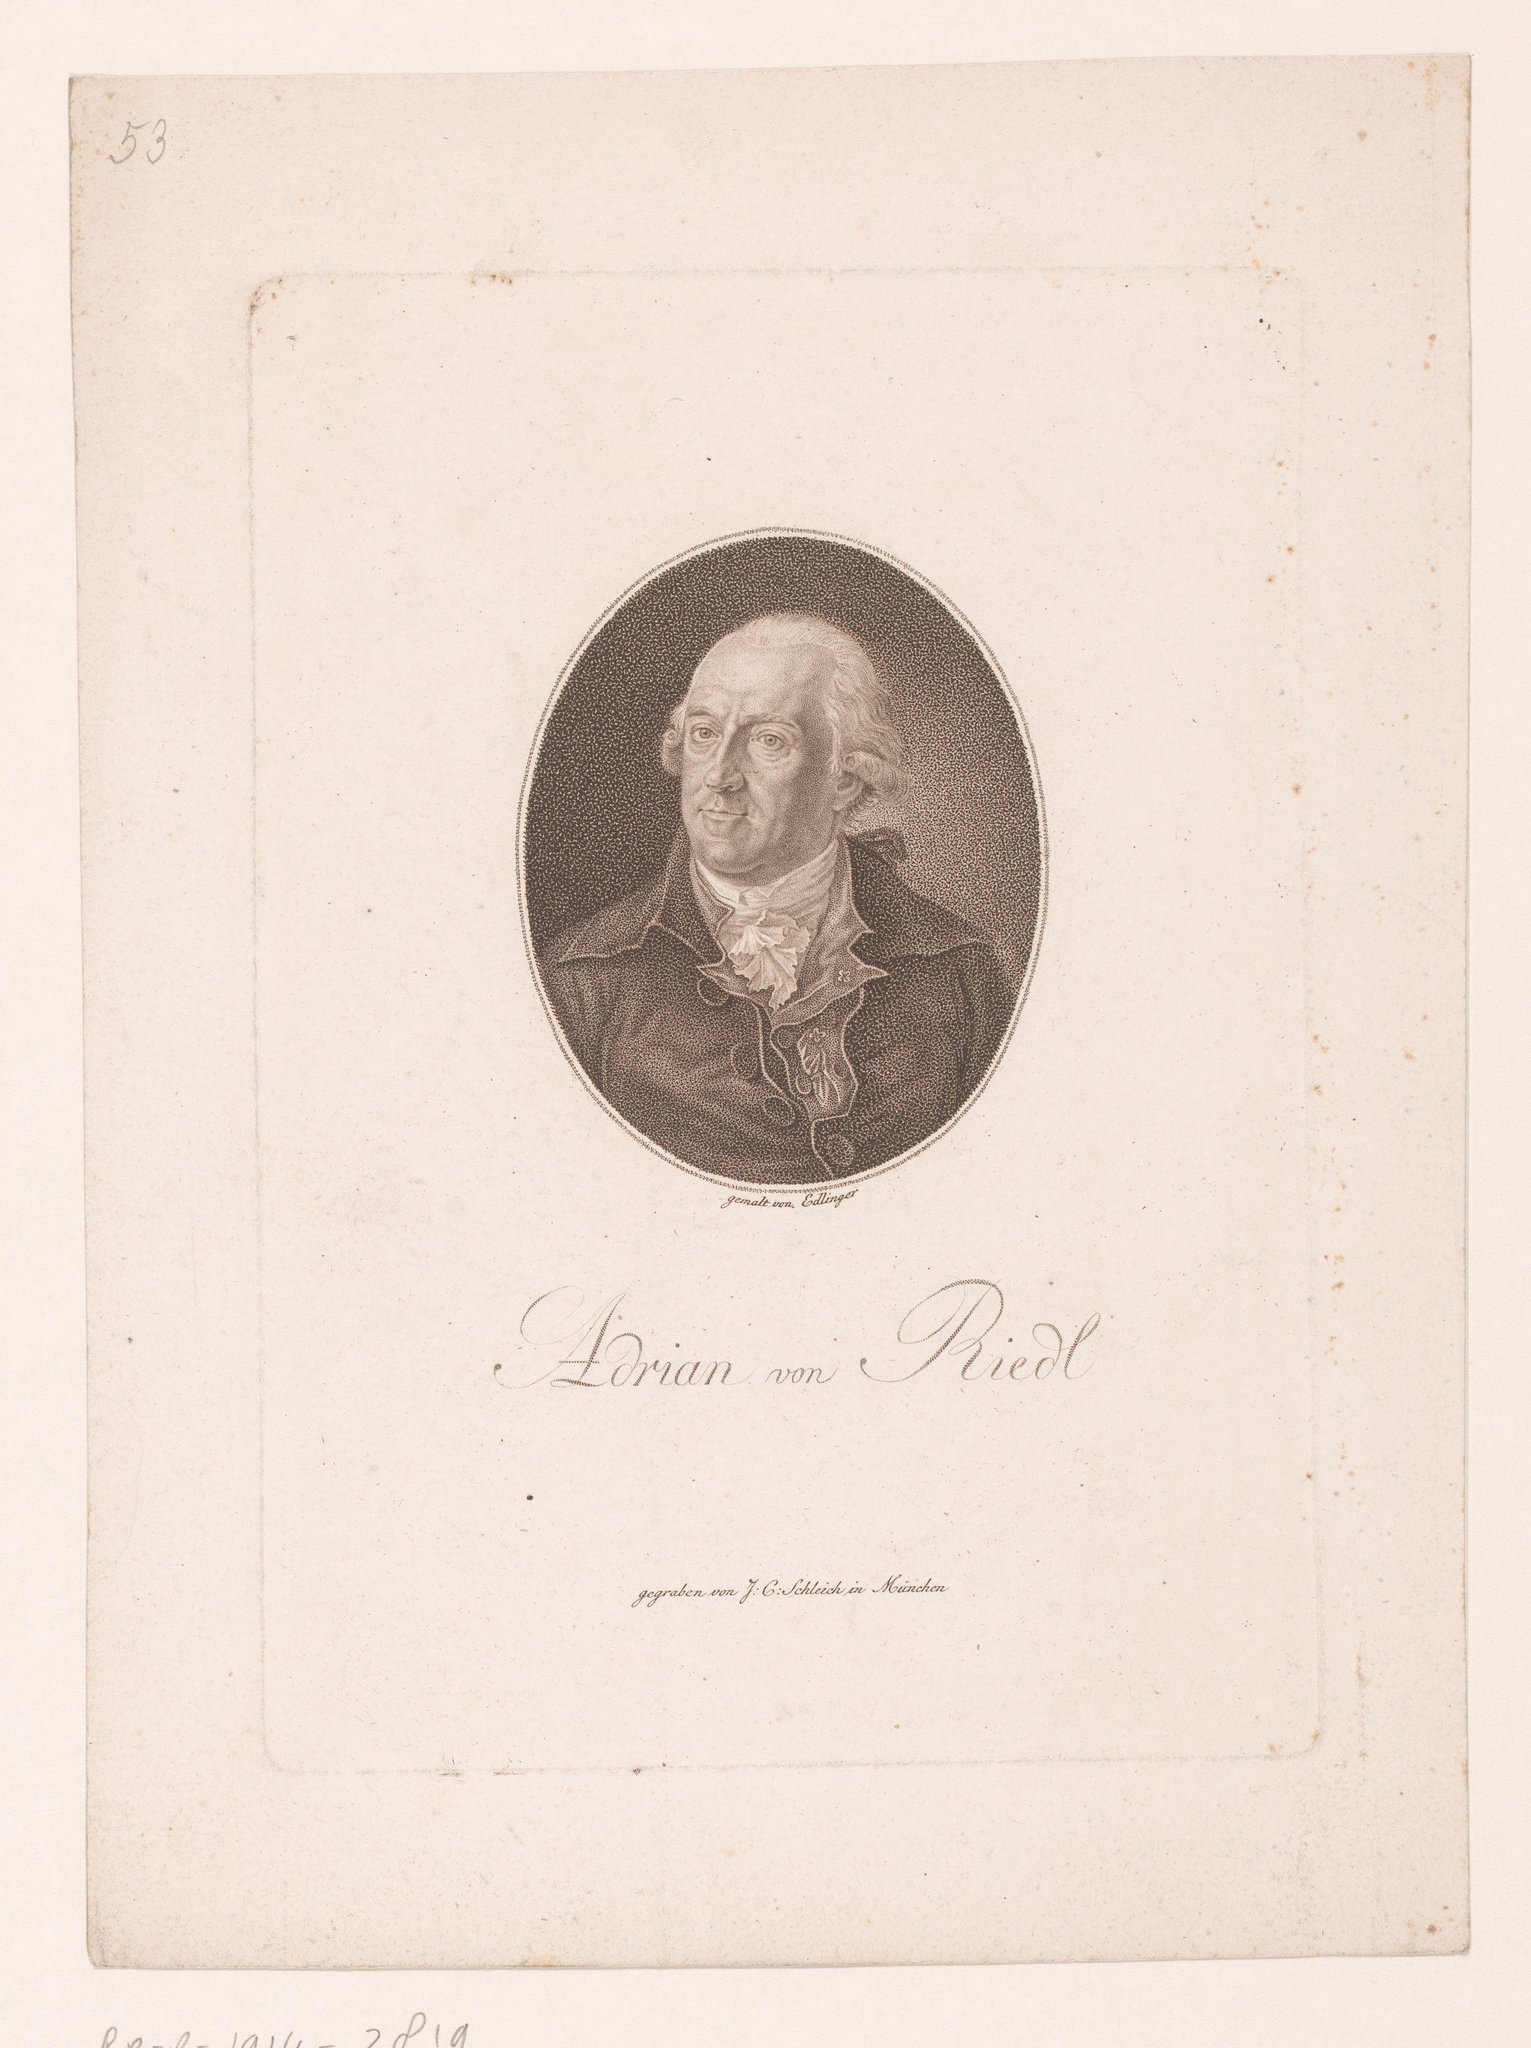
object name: print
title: Portret van Adrian von Riedl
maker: johann carl schleich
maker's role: print maker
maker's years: 1759-1842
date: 1769-1842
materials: paper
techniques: printing, engraving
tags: historical persons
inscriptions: collector's mark: Lugt 2228